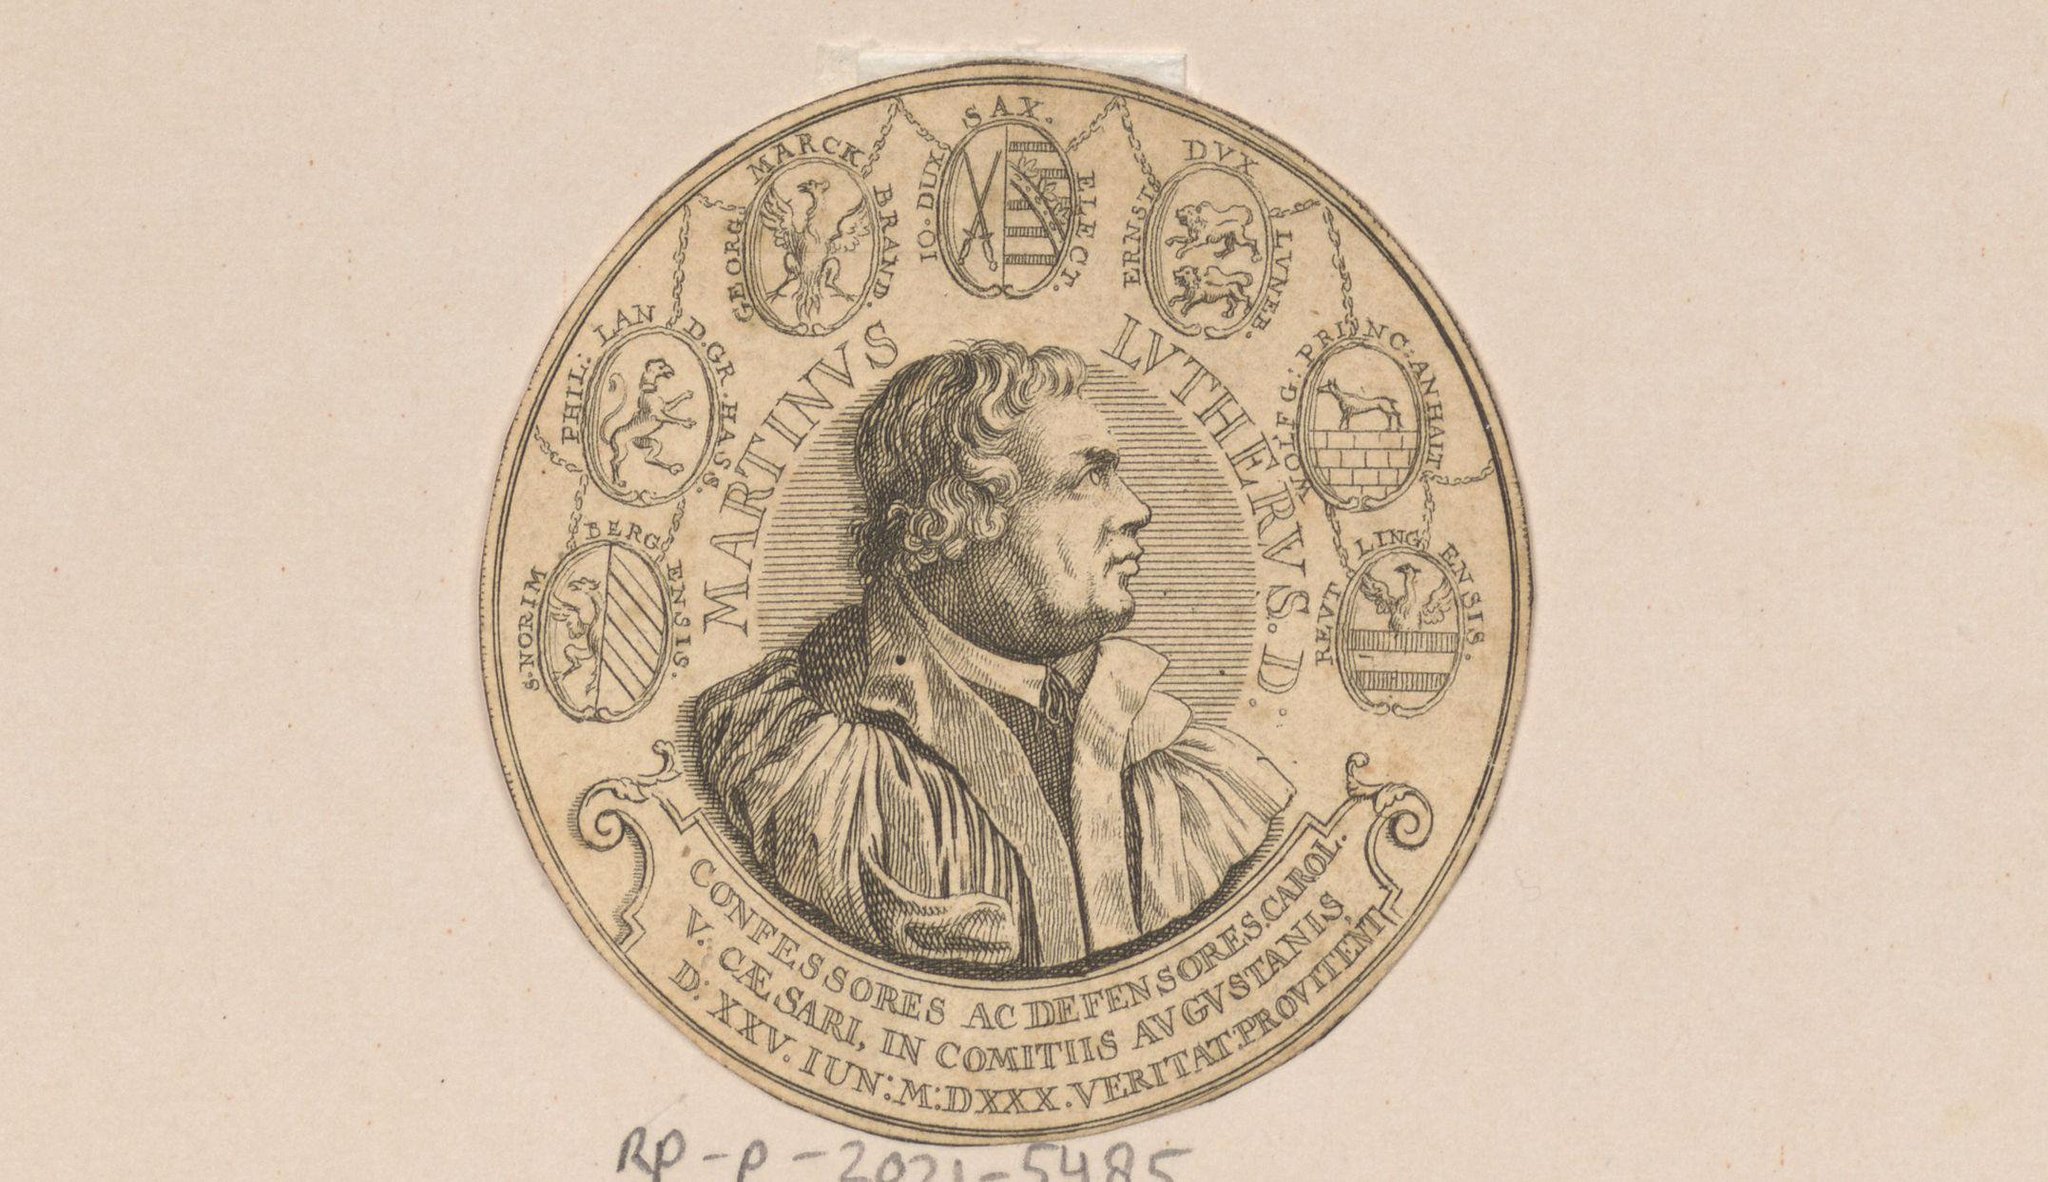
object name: print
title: Penning met het portret van Martin Luther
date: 1730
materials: paper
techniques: etching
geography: northern netherlands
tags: priest, martin luther, theologian, historical persons, medal (considered as a piece of sculpture, regardless of its specific function)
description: Prent waarschijnlijk uit: Europische Mercurius (...). 41 (1730), dl. 1.